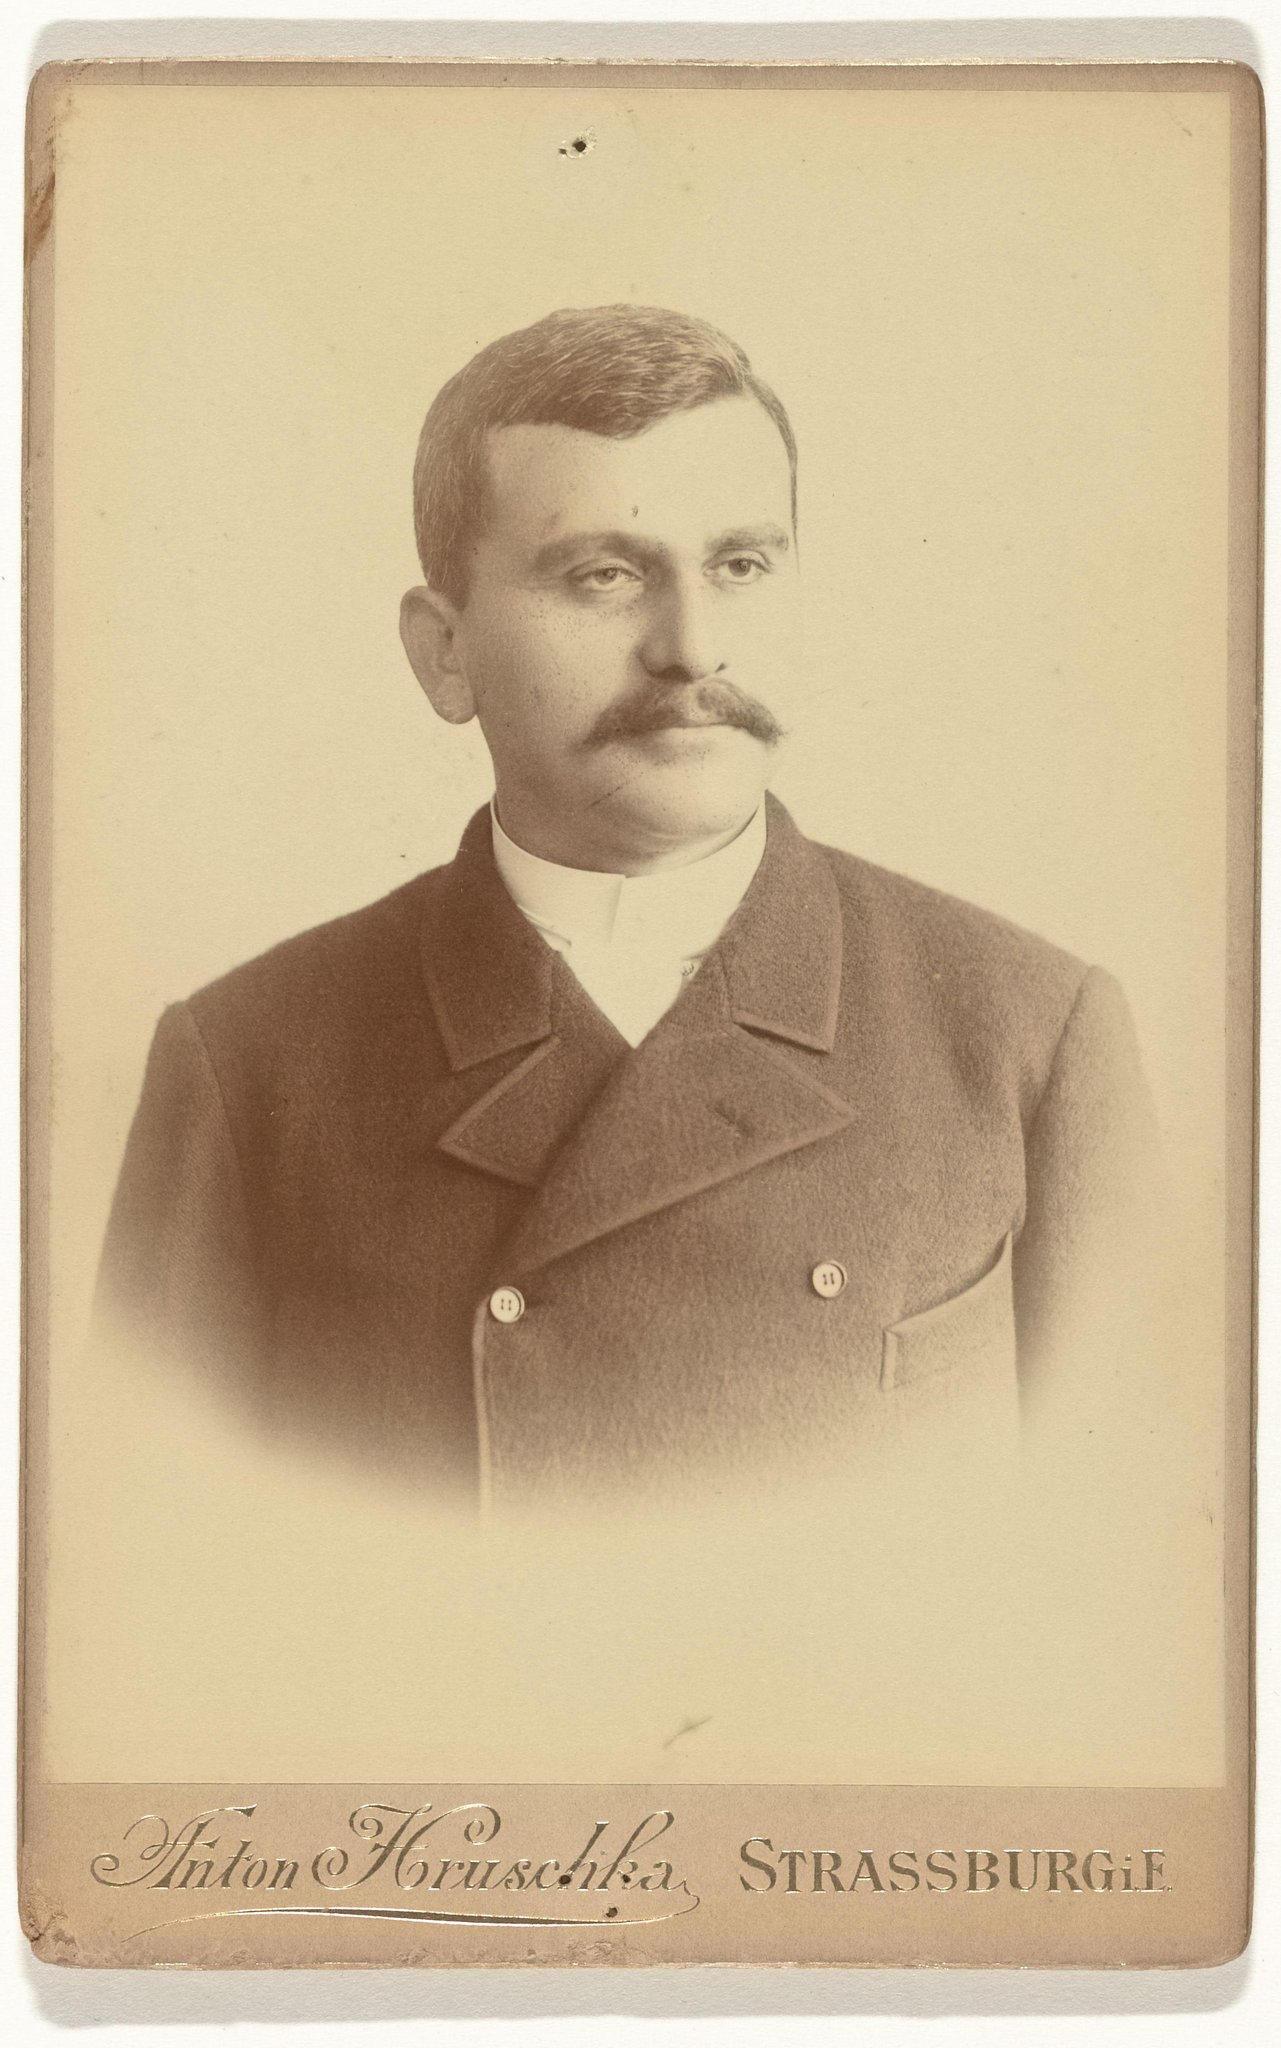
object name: photograph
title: Portret van een onbekende, mogelijk Meir Wachenheimer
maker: anton hruschka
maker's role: fotograaf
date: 1870-1920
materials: photographic support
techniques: gelatin silver print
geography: straatsburg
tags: straatsburg (frankrijk)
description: Portret van een onbekende man met snor, dichte witte boord en bovenkleed met twee sluitknopen